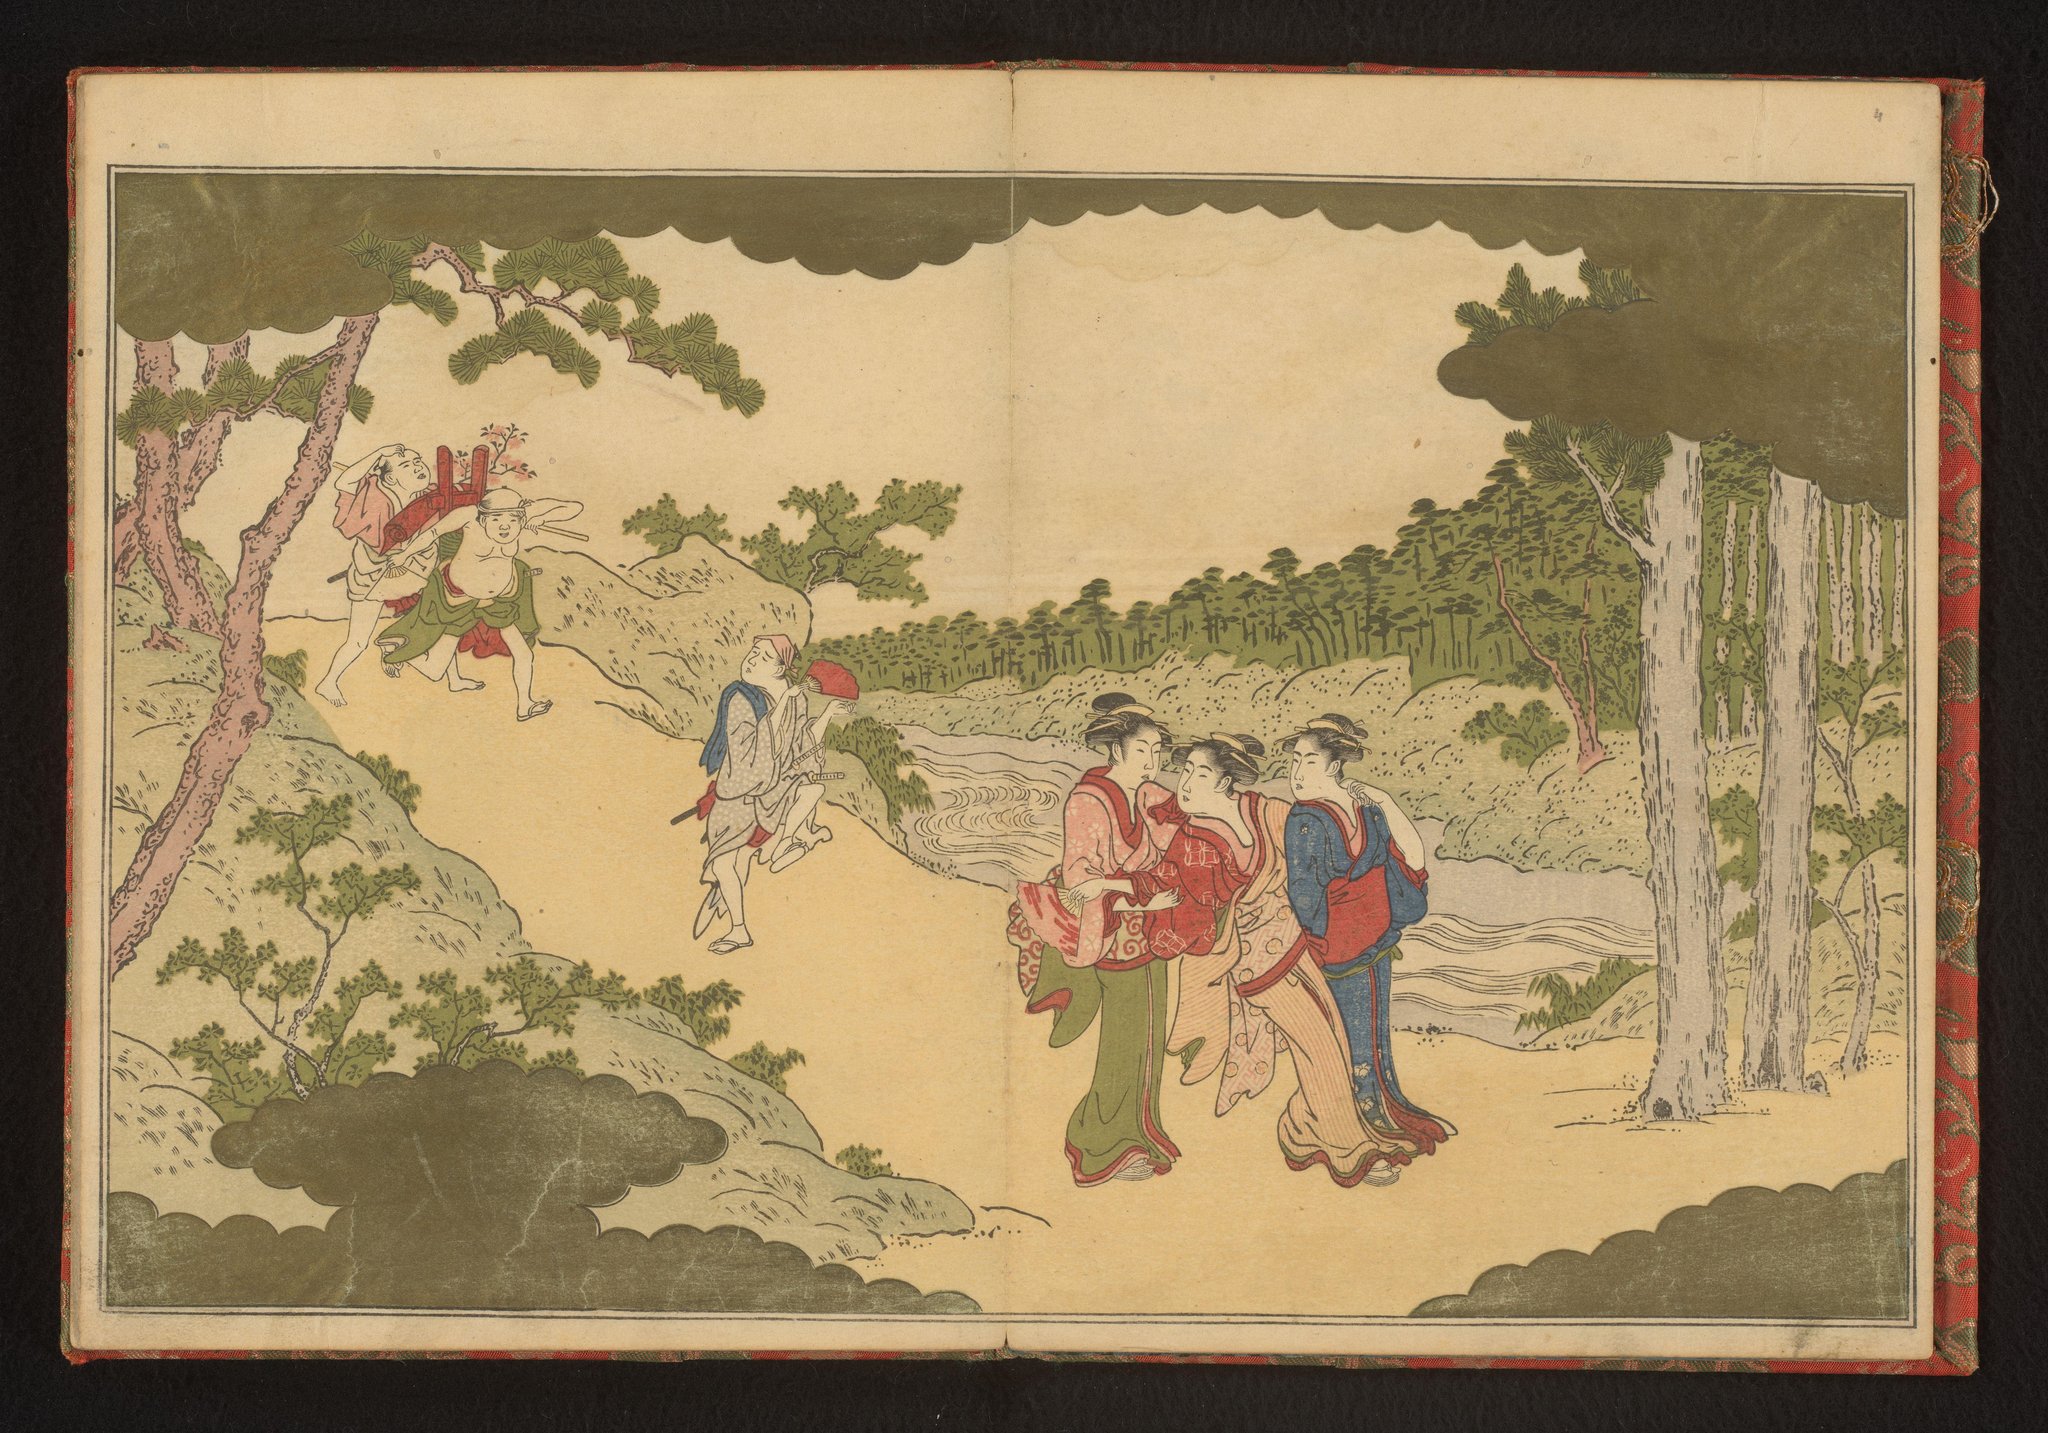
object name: page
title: People returning from a flower-viewing party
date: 1790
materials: gold powder, paper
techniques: woodcut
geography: edo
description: Zevende en achtste pagina uit het boek Fugenzo van Utamaro.